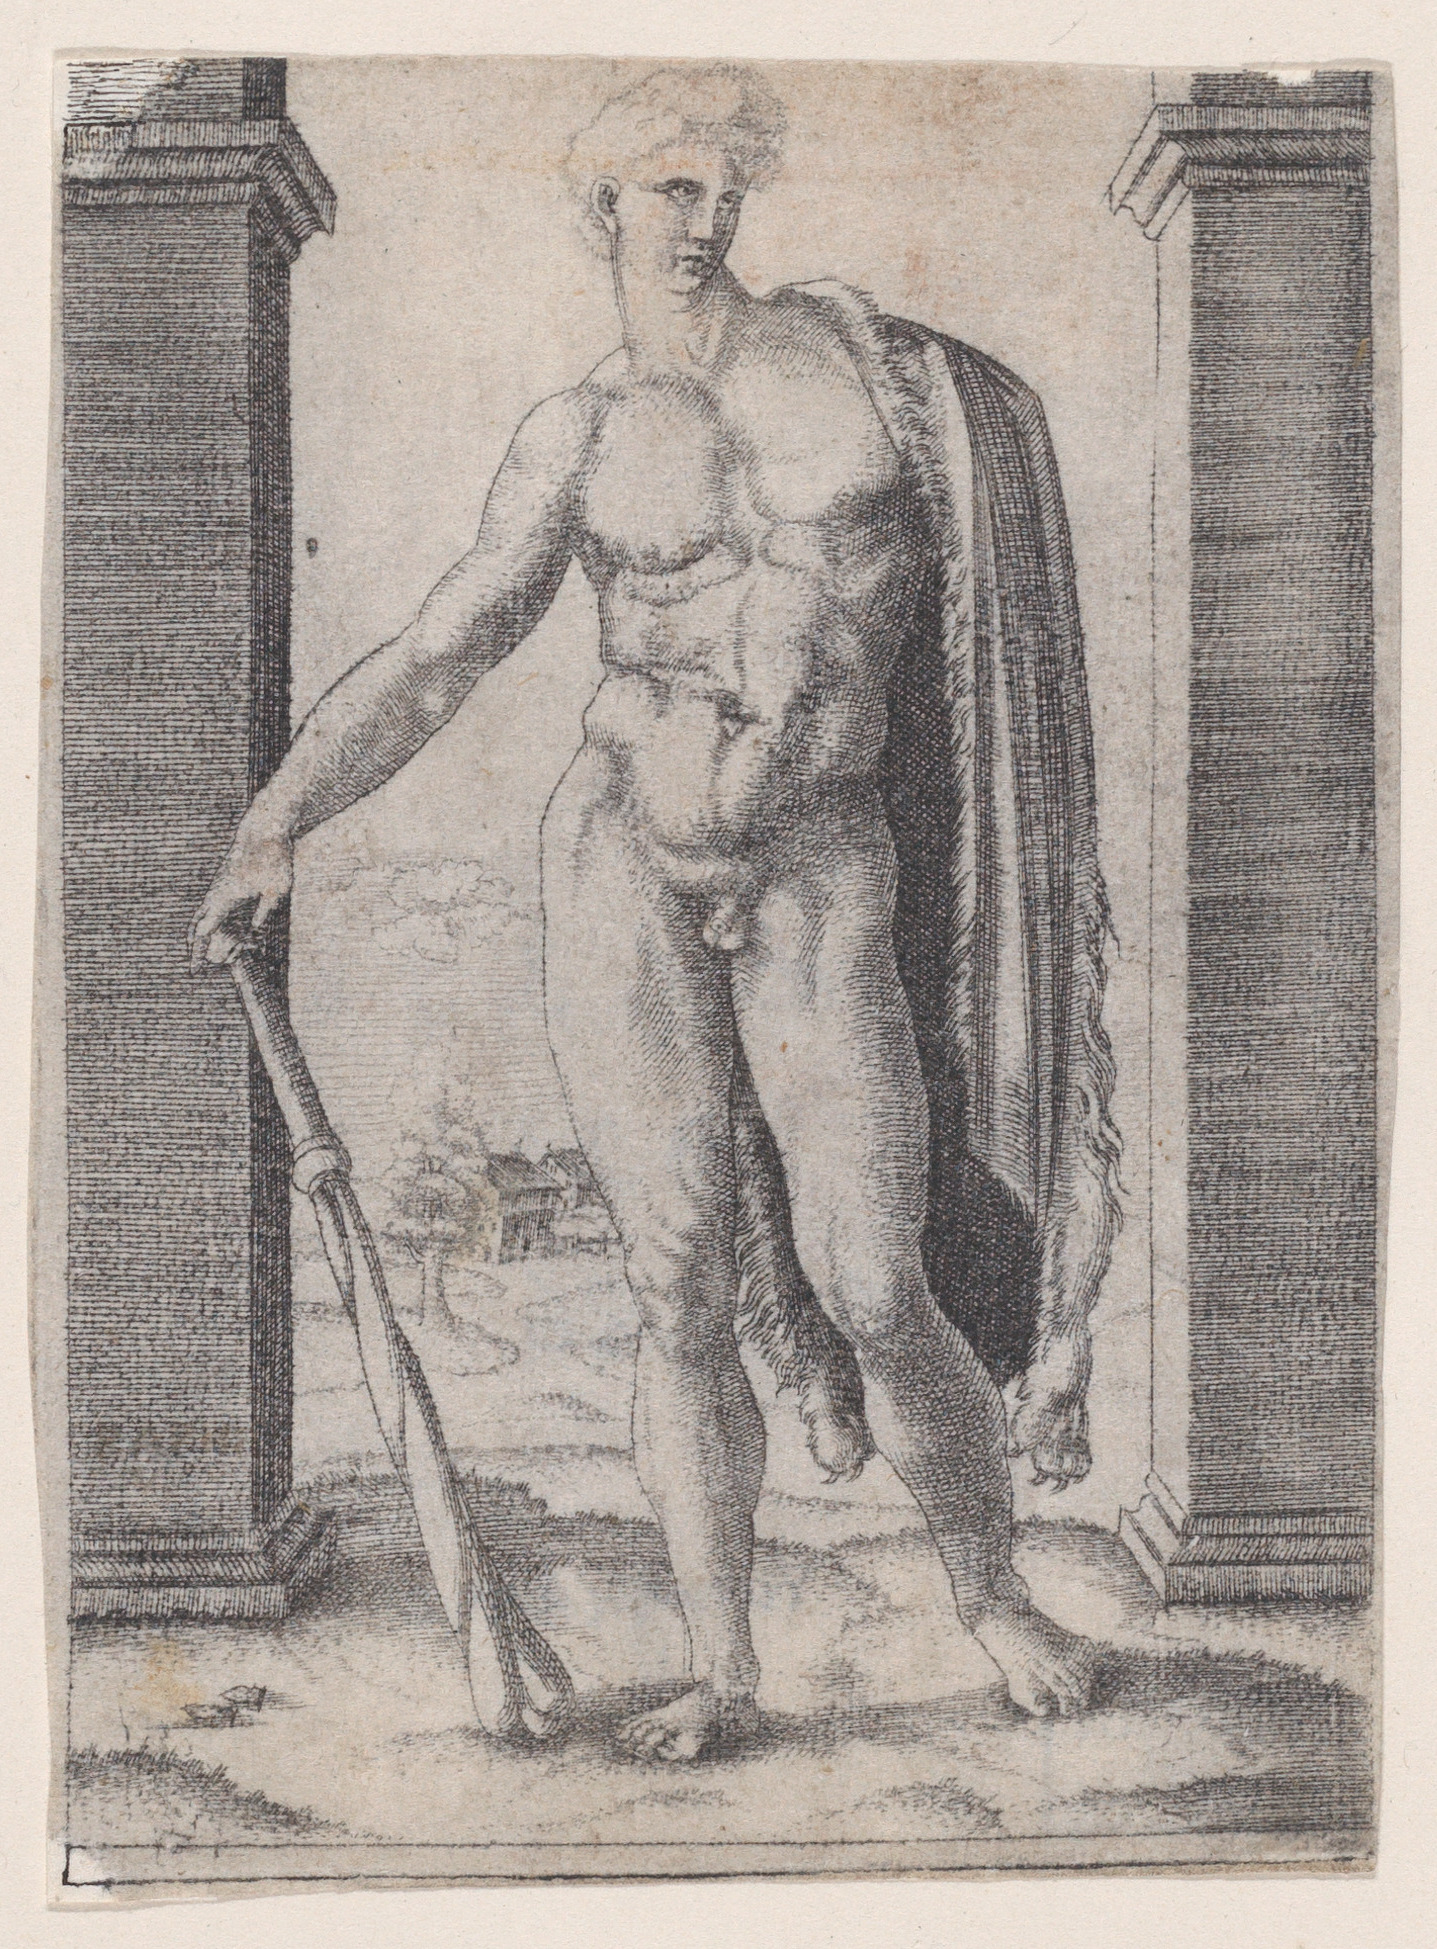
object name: print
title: Young Hercules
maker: agostino veneziano (agostino dei musi)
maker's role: artist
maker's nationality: italian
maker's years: 1490-1536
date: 1514-1536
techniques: engraving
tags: male nudes,hercules